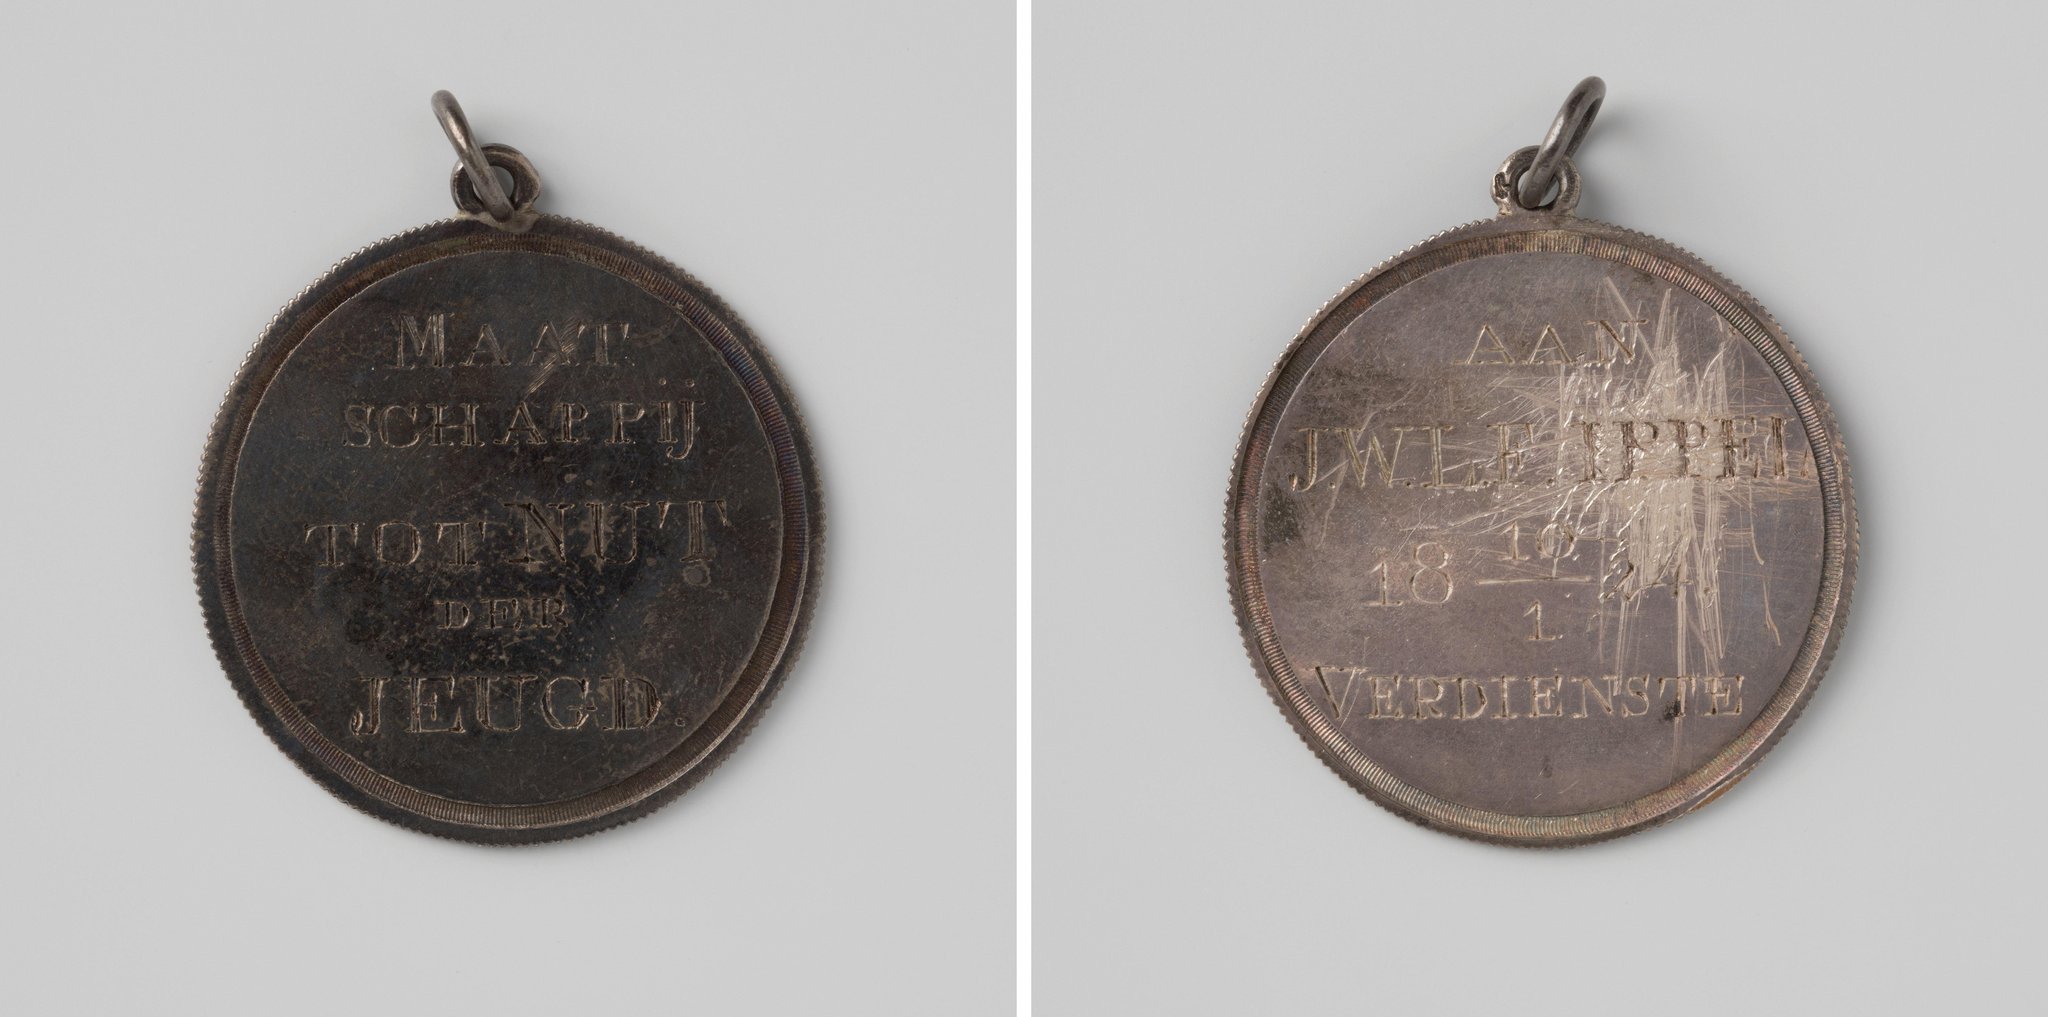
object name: medal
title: Erepenning van de Maatschappij tot Nut der Jeugd op naam van J.W.L.F. Ippel 1824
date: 1824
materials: silver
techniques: engraving, pressing, scoring, soldering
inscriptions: inscription: ‘AAN / J.W.L.F. IPPEL / 18 10/1 24 / VERDIENSTE’, inscription: ‘MAAT / SCHAPPIJ / TOT NUT / DER / JEUGD’, hallmark: ‘(zwaardje)’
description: Zilveren gegraveerde penning met oog en draagring, op de voorzijde vijf, op de keerzijde vier regels tekst gegraveerd, met kartelrand.